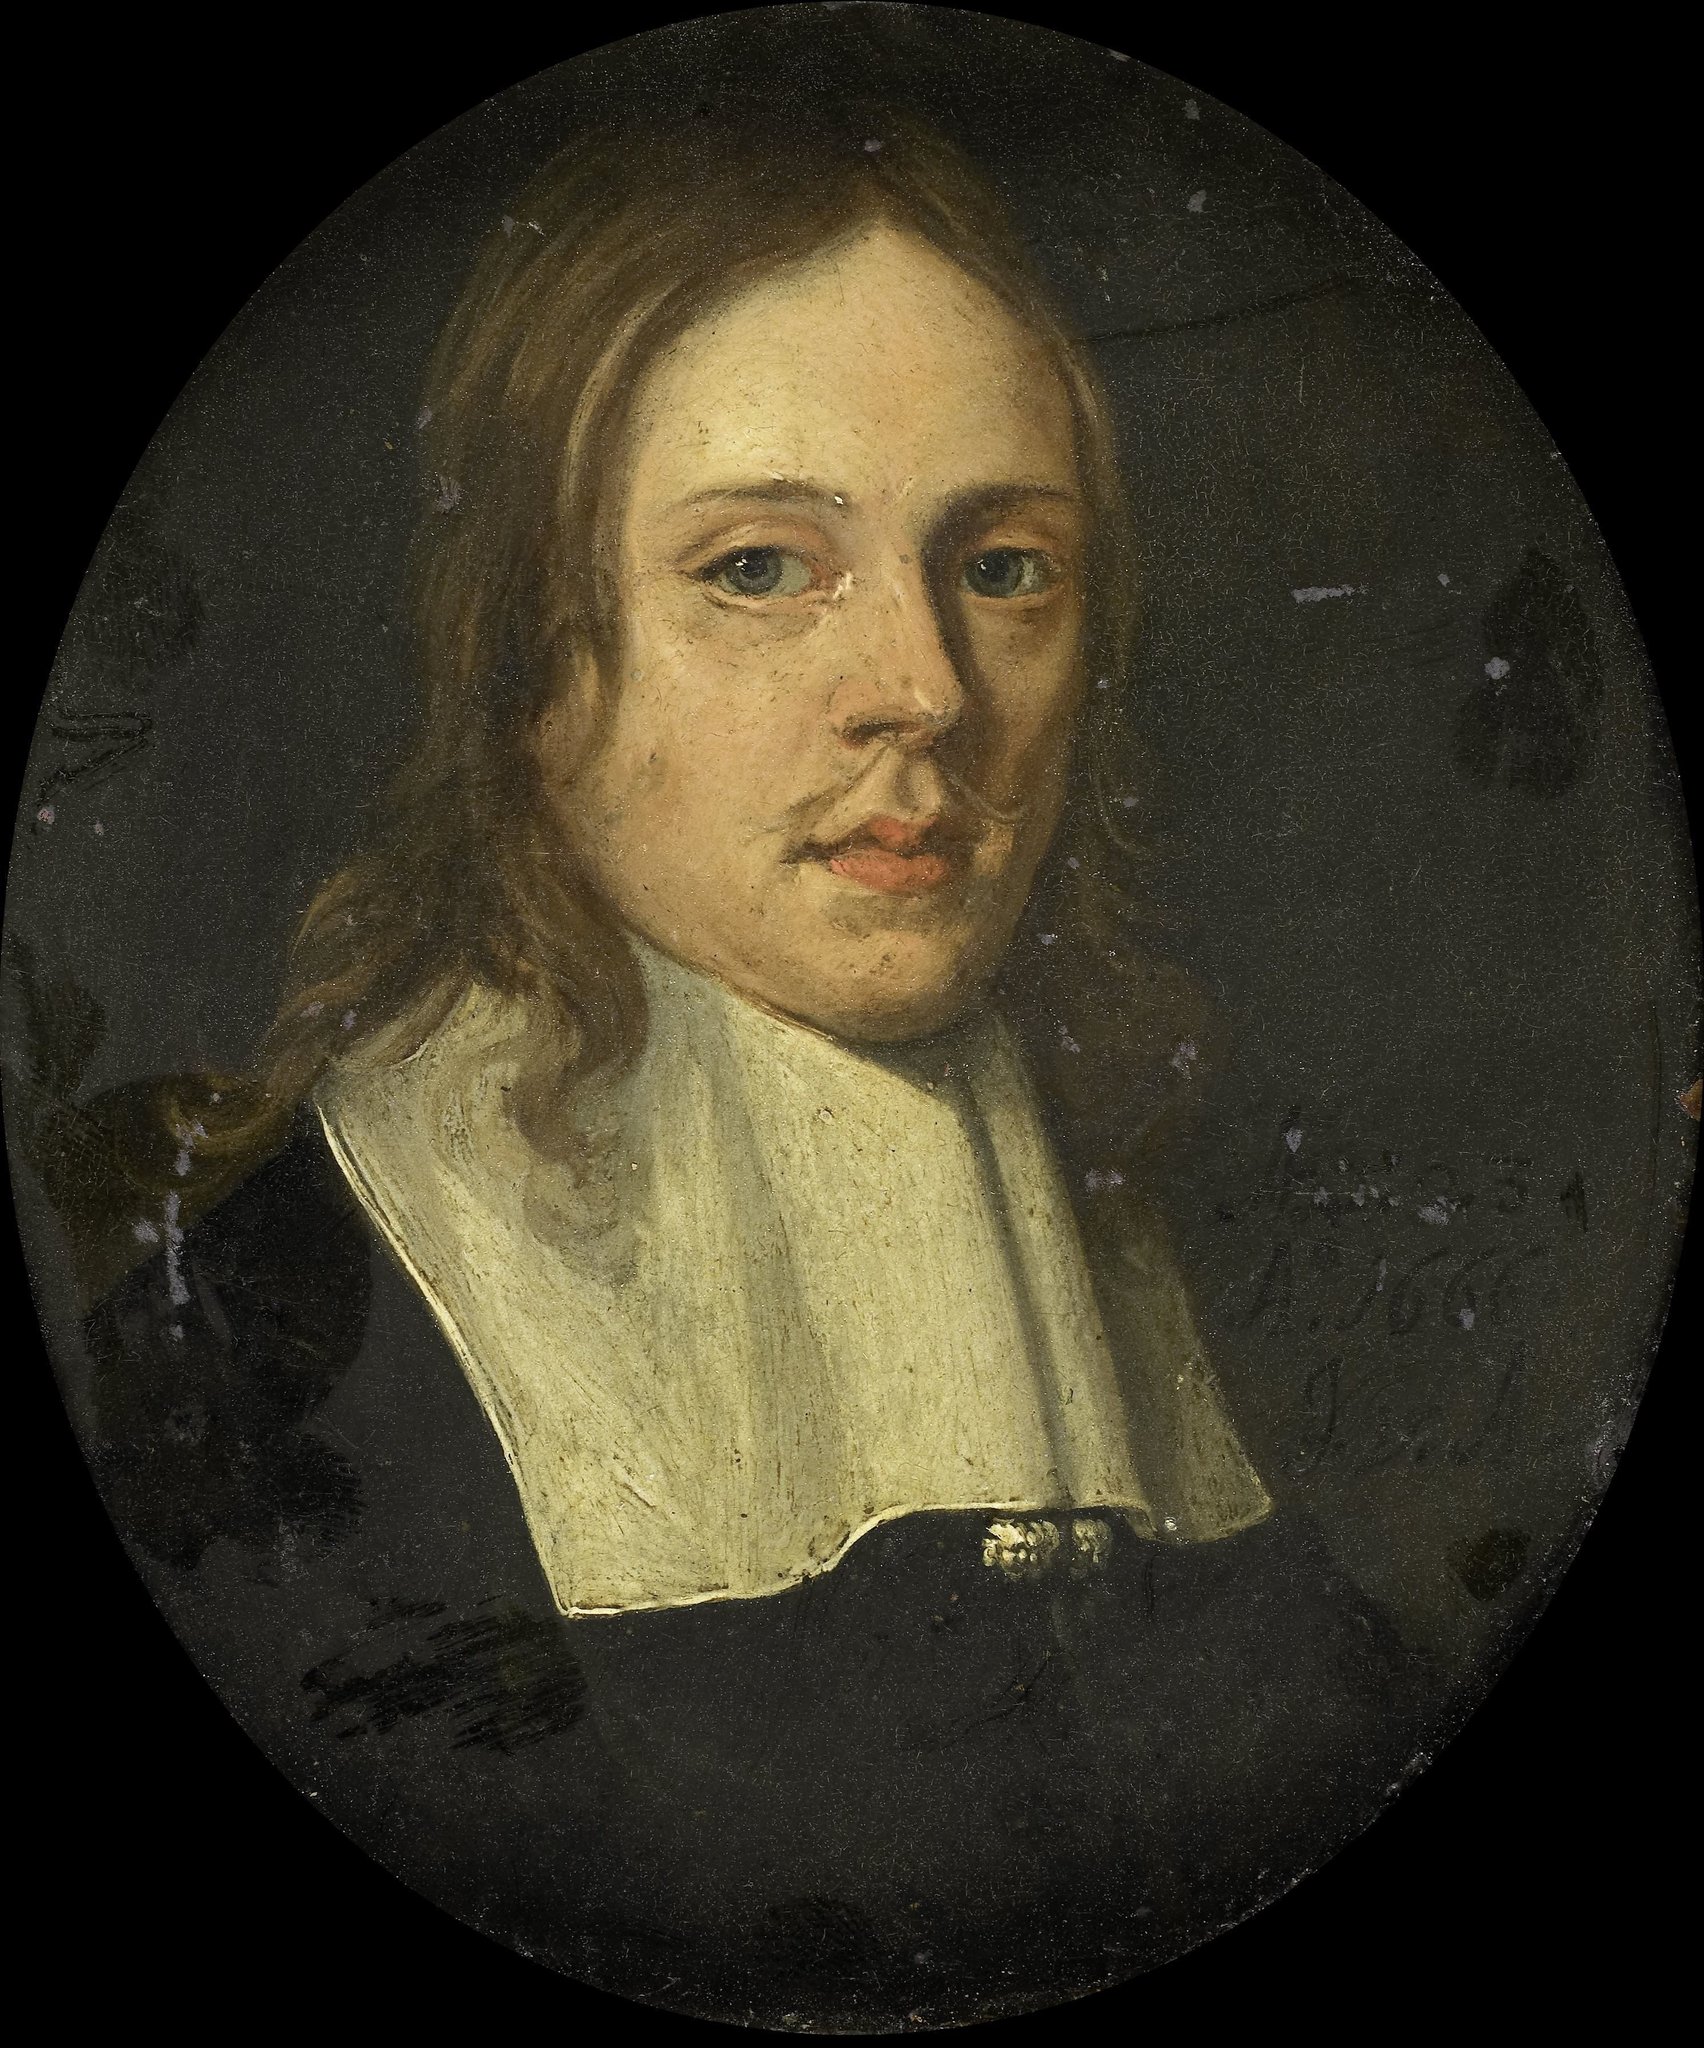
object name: painting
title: Portrait of a Man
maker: jan van assen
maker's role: painter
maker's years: 1635-1695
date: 1666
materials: copper, oil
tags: historical persons not known by name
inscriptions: signature and date: ‘AET 23 Aº 1666 J.v.A.’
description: Portret van een jonge man. Buste naar rechts, het gezicht naar de beschouwer gewend.